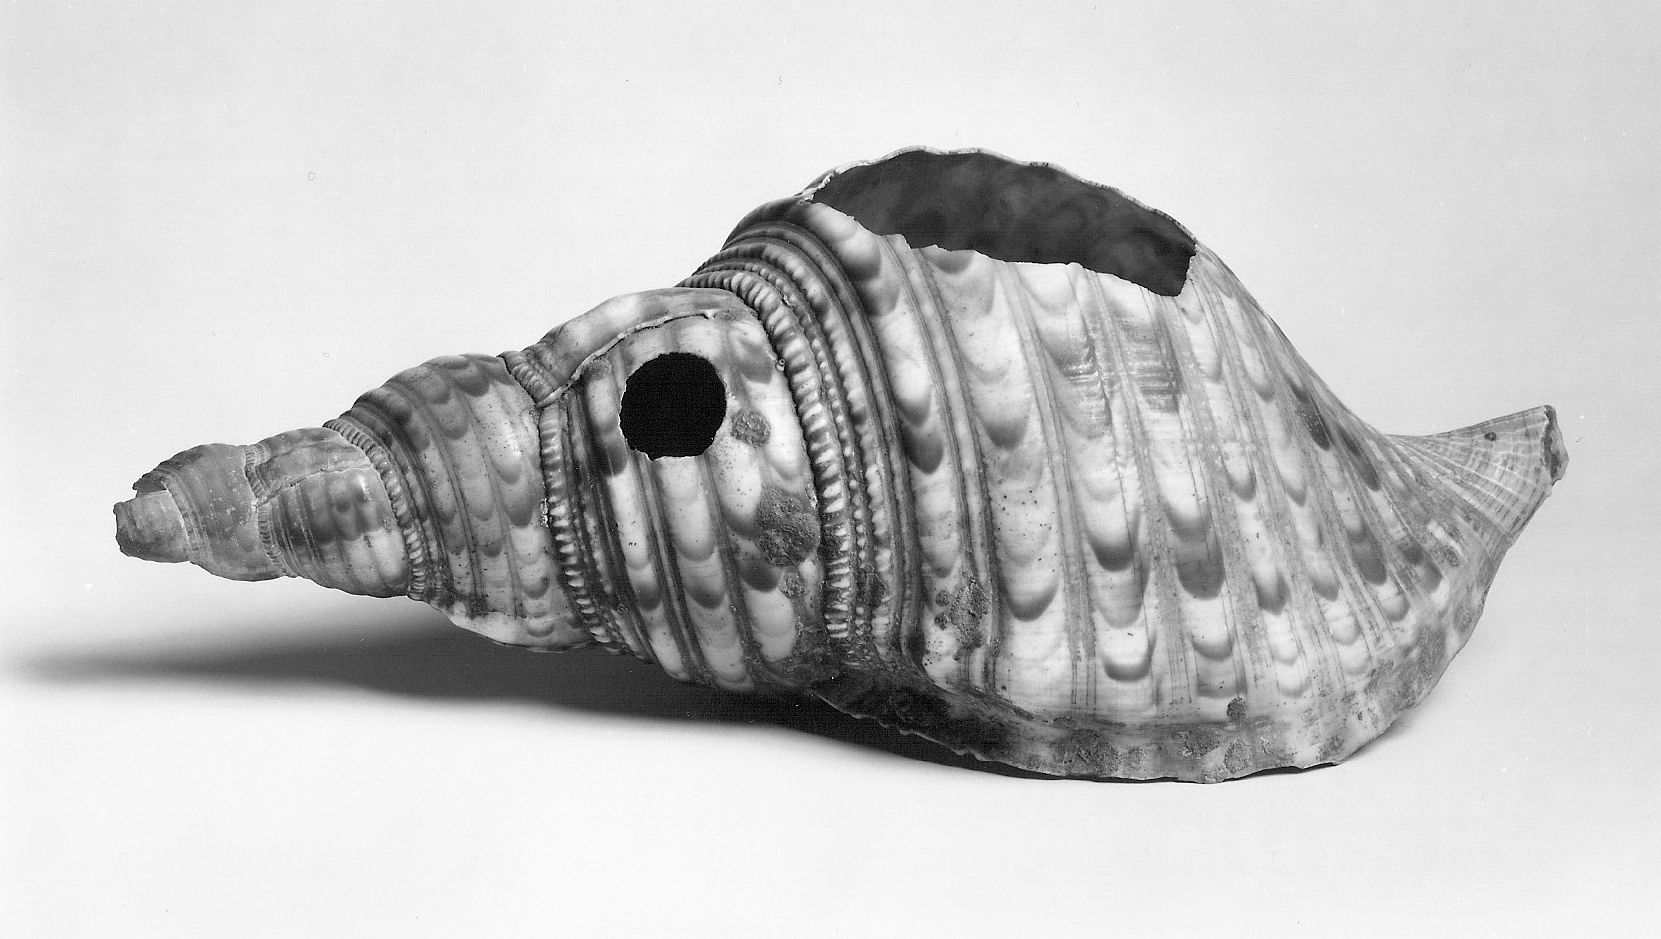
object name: antsiva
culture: malagasy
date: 1867-1900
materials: shell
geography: madagascar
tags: shells